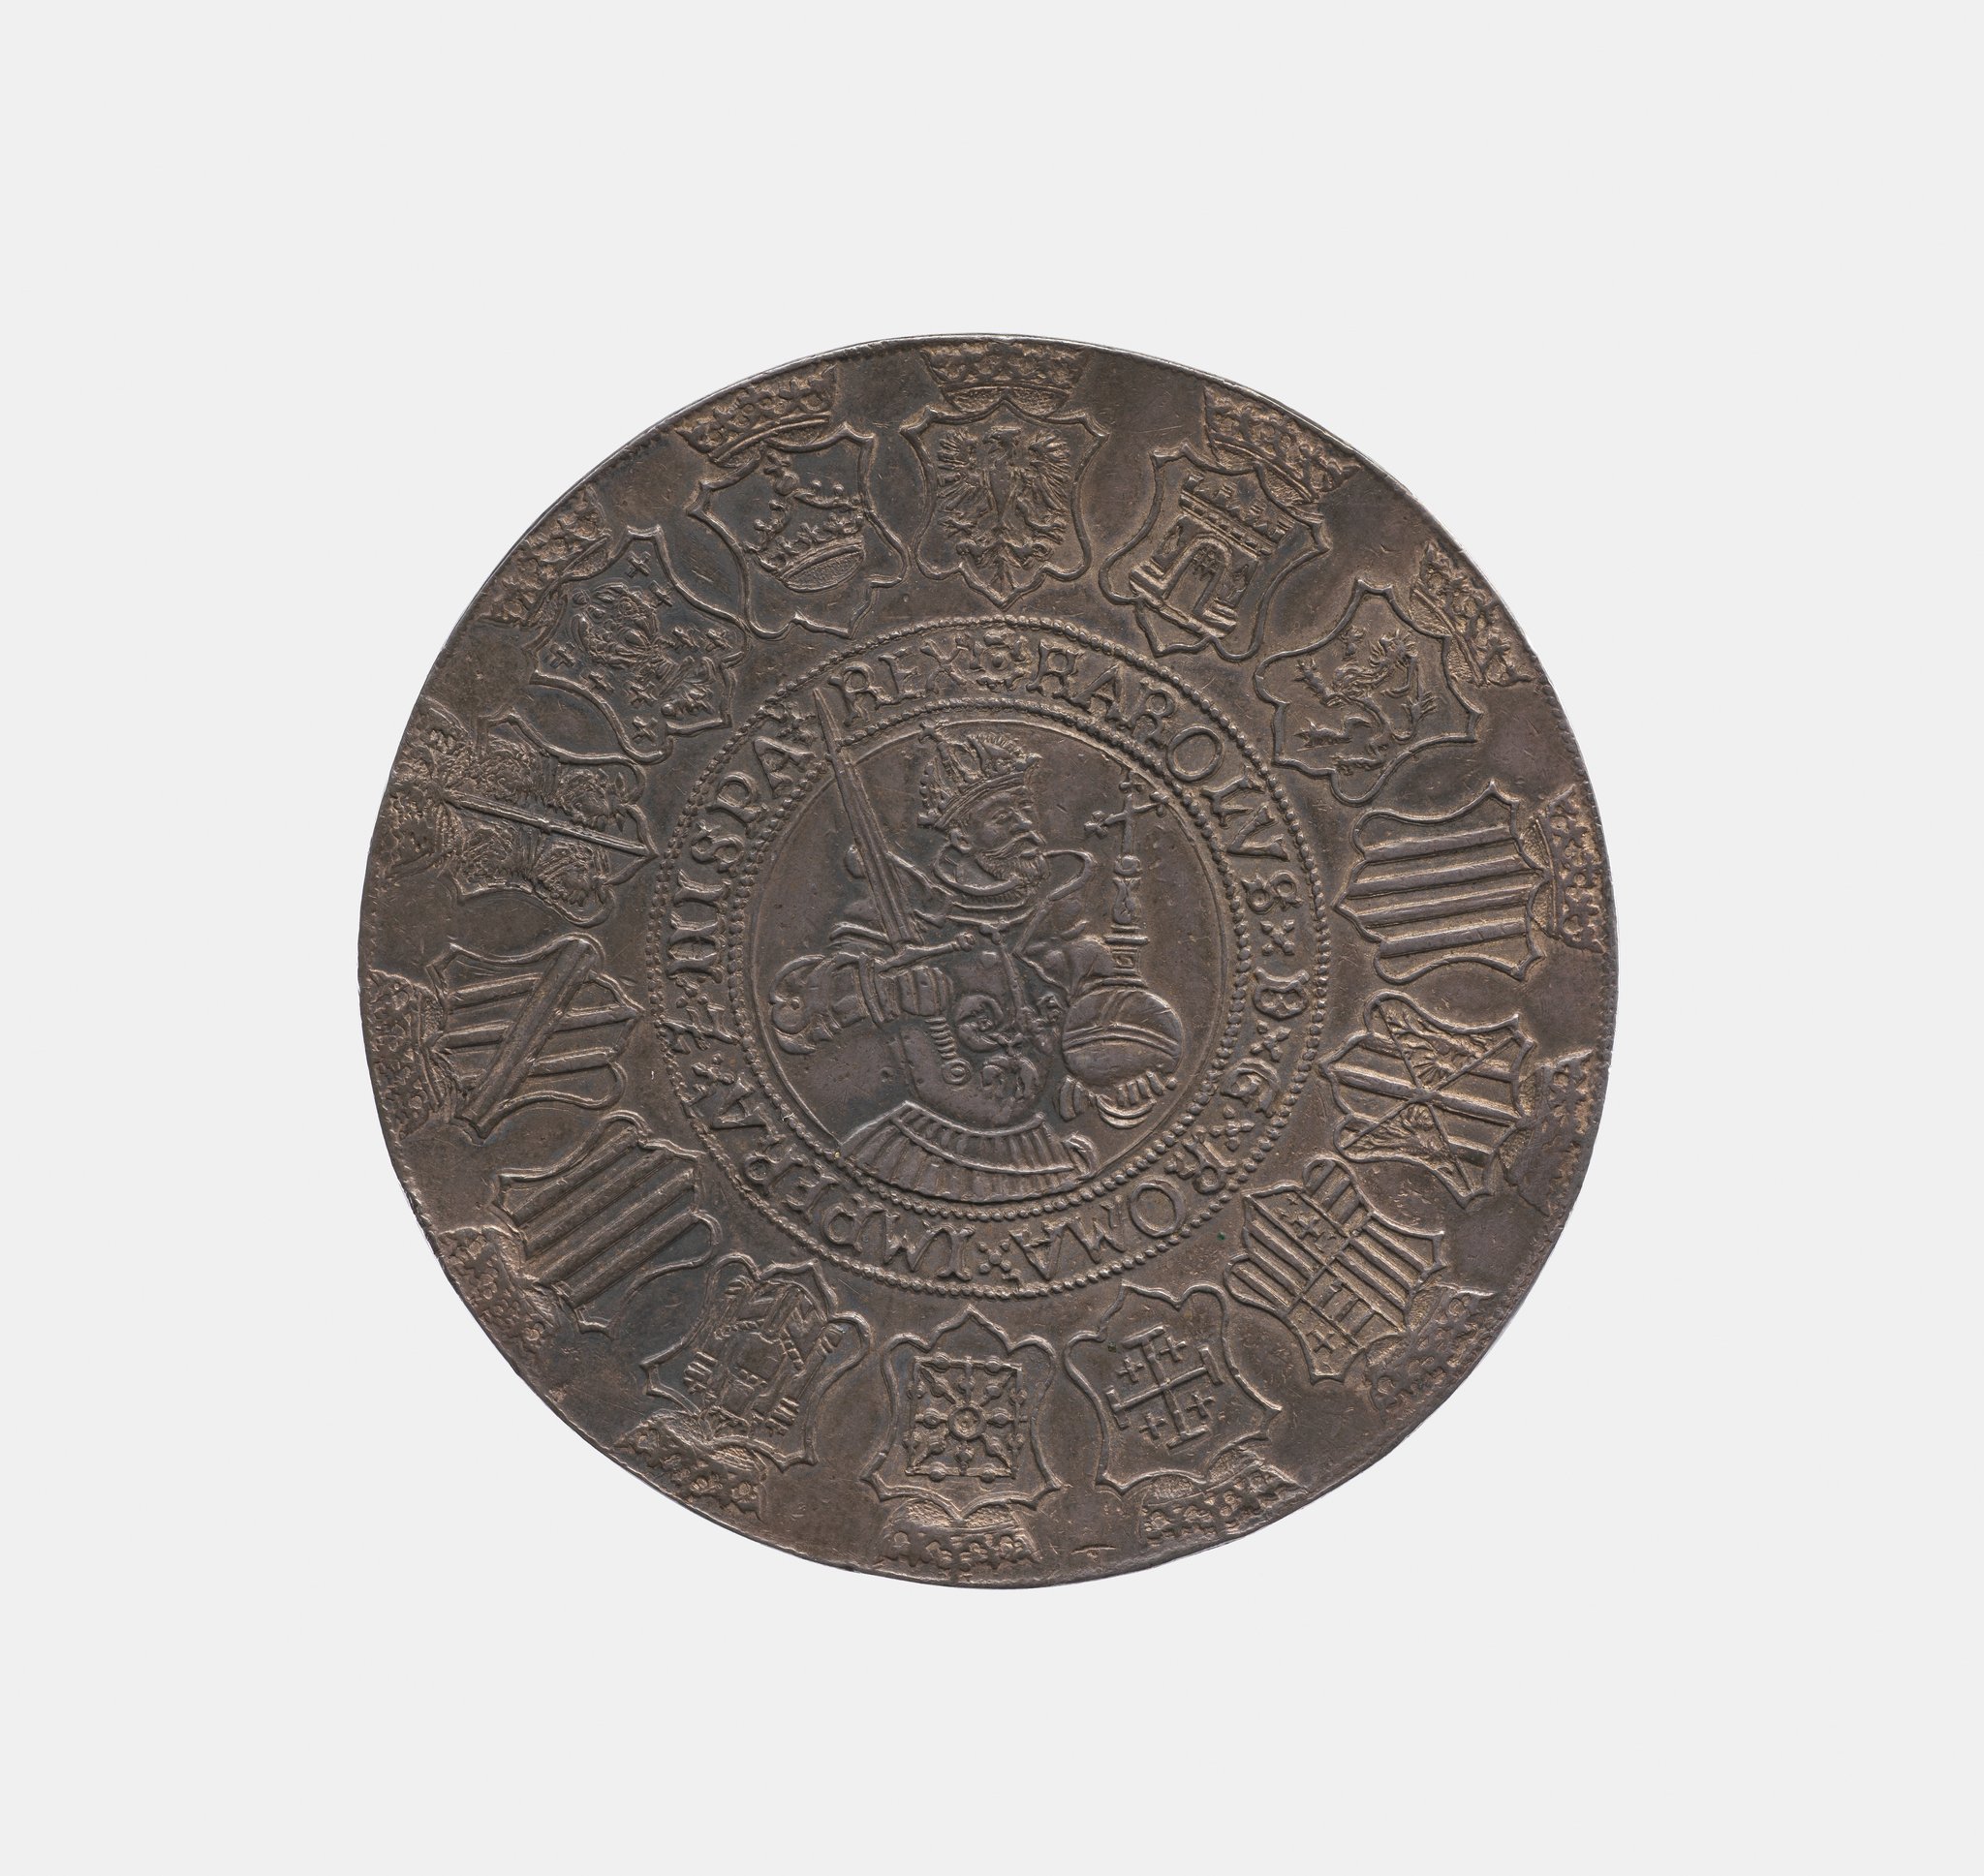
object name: thaler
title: Charles V, Holy Roman Emperor (1 1/2 Schautaler)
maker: Anonymous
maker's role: artist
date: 1532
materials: silver